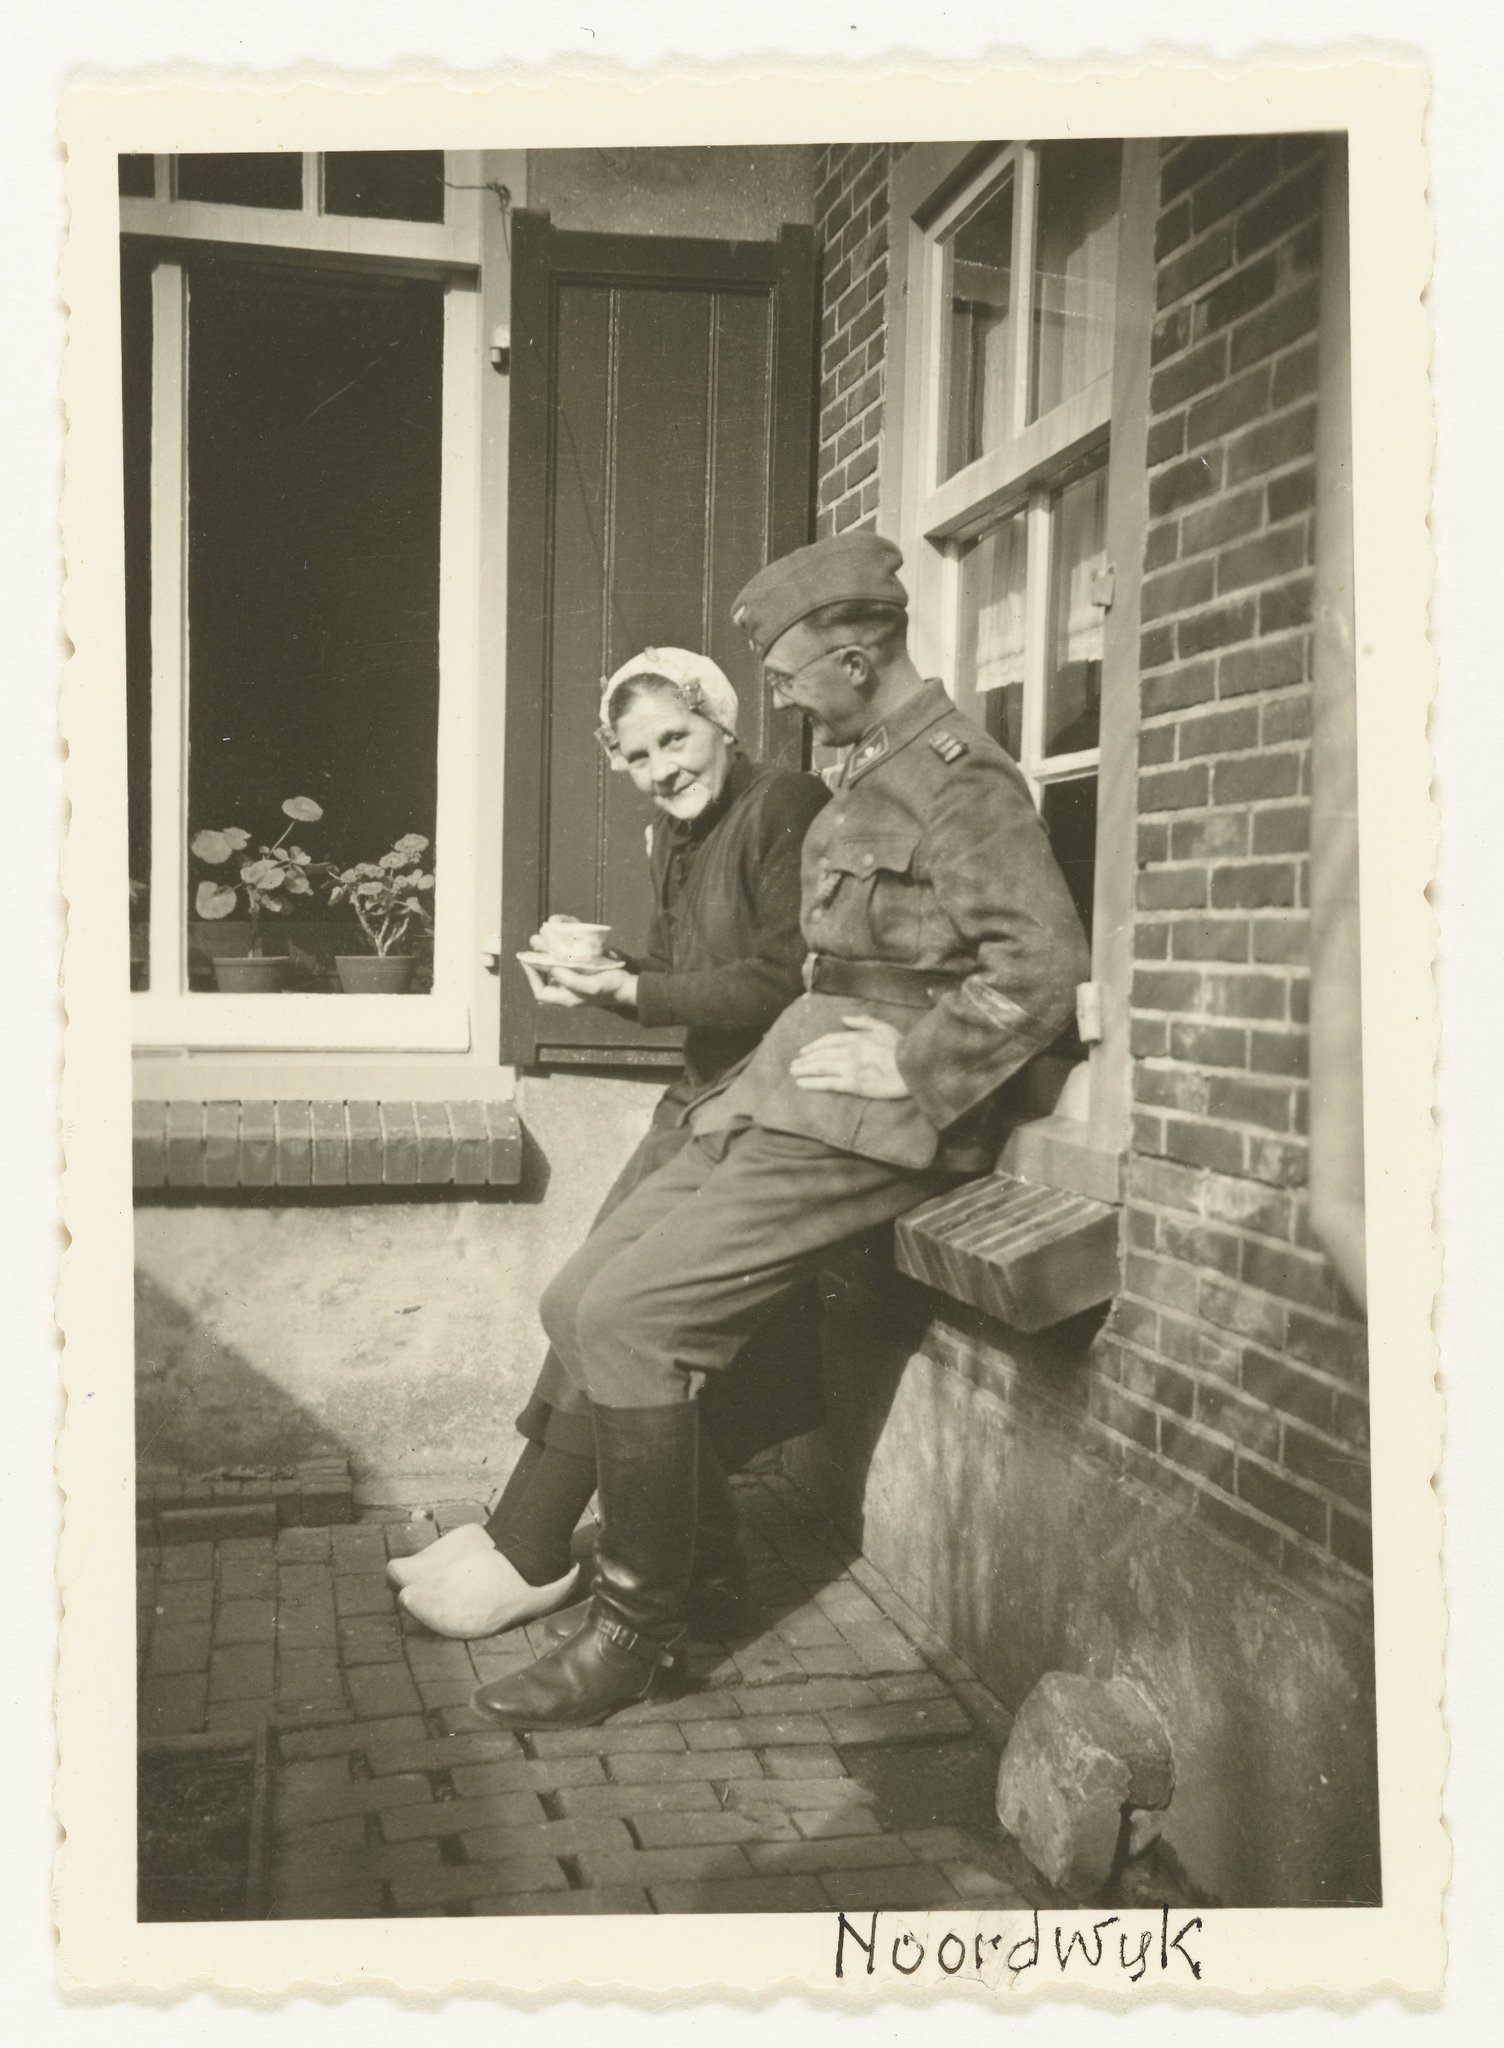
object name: photograph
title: Duitse soldaat met oudere vrouw met kopje koffie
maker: Anonymous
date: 1941-1943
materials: photographic support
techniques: gelatin silver print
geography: noordwijk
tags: occupier and civilians, occupation ~ war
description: Een Duitse militair leunt op een vensterbank en kijkt naar een oudere vrouw links van hem die een kopje koffie vast houdt en in de camera kijkt. De vrouw heeft een kapje met oorijzers op haar hoofd en klompen aan. Achter het raam staan geraniums. In Noordwijk.